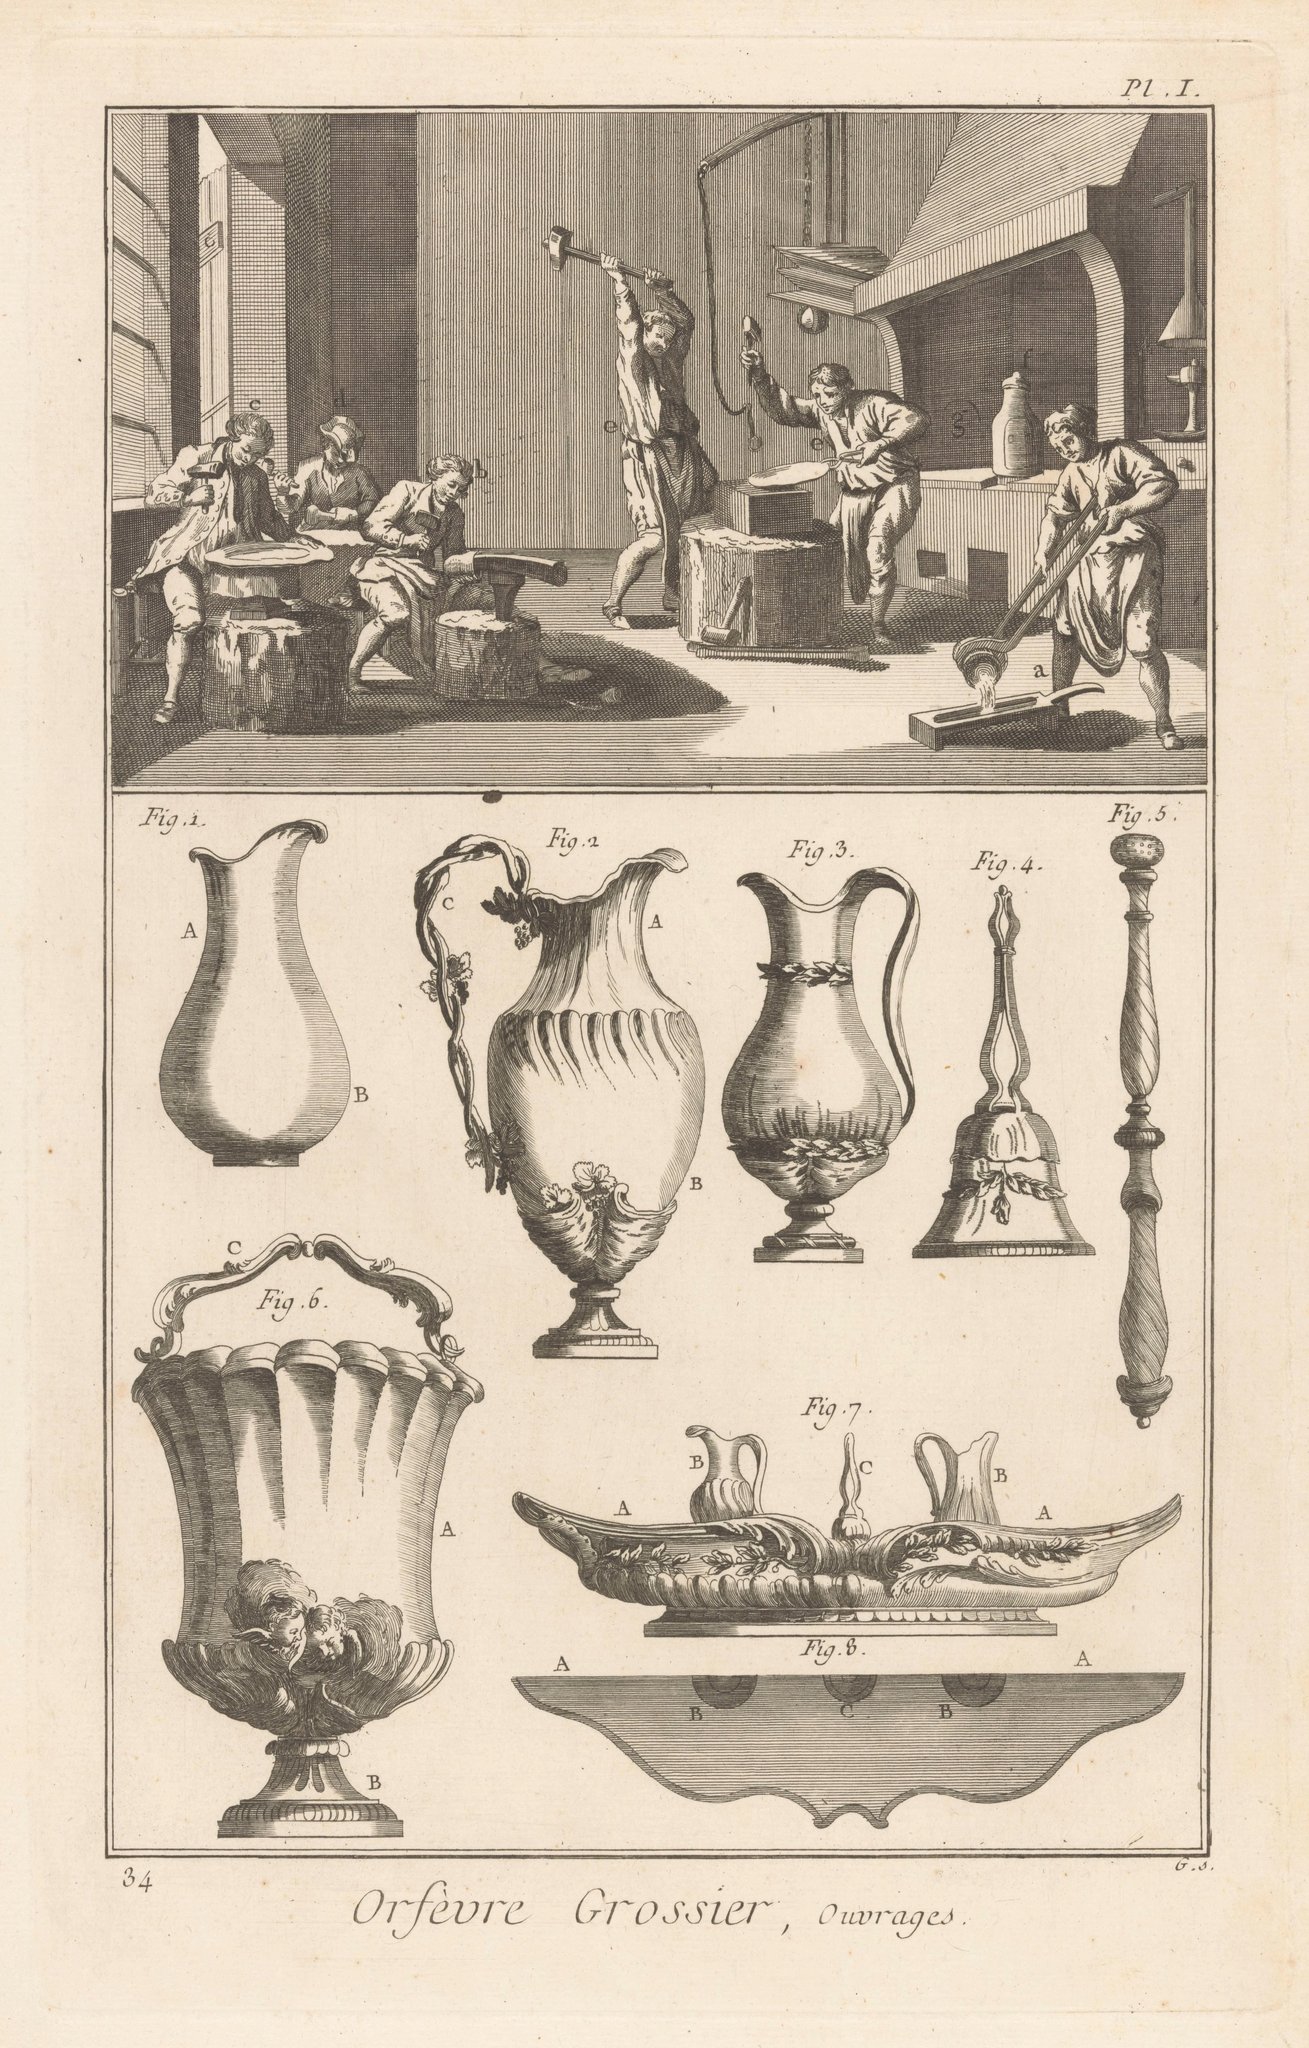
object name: book illustration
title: Orfèvre Grossier, Ouvrages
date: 1770-1780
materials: paper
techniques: engraving, etching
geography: yverdon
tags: jeweller, goldsmith, silversmith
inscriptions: collector's mark: Lugt 2228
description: Prent uit: Diderot, Denis en d'Alembert, Jean Baptiste le Rond. Encyclopédie ou dictionnaire universel raisonné des connoissances humaines. Yverdon: Felice, Fortunatio Bartolomeo de, 1770-1780. Pagina 34.